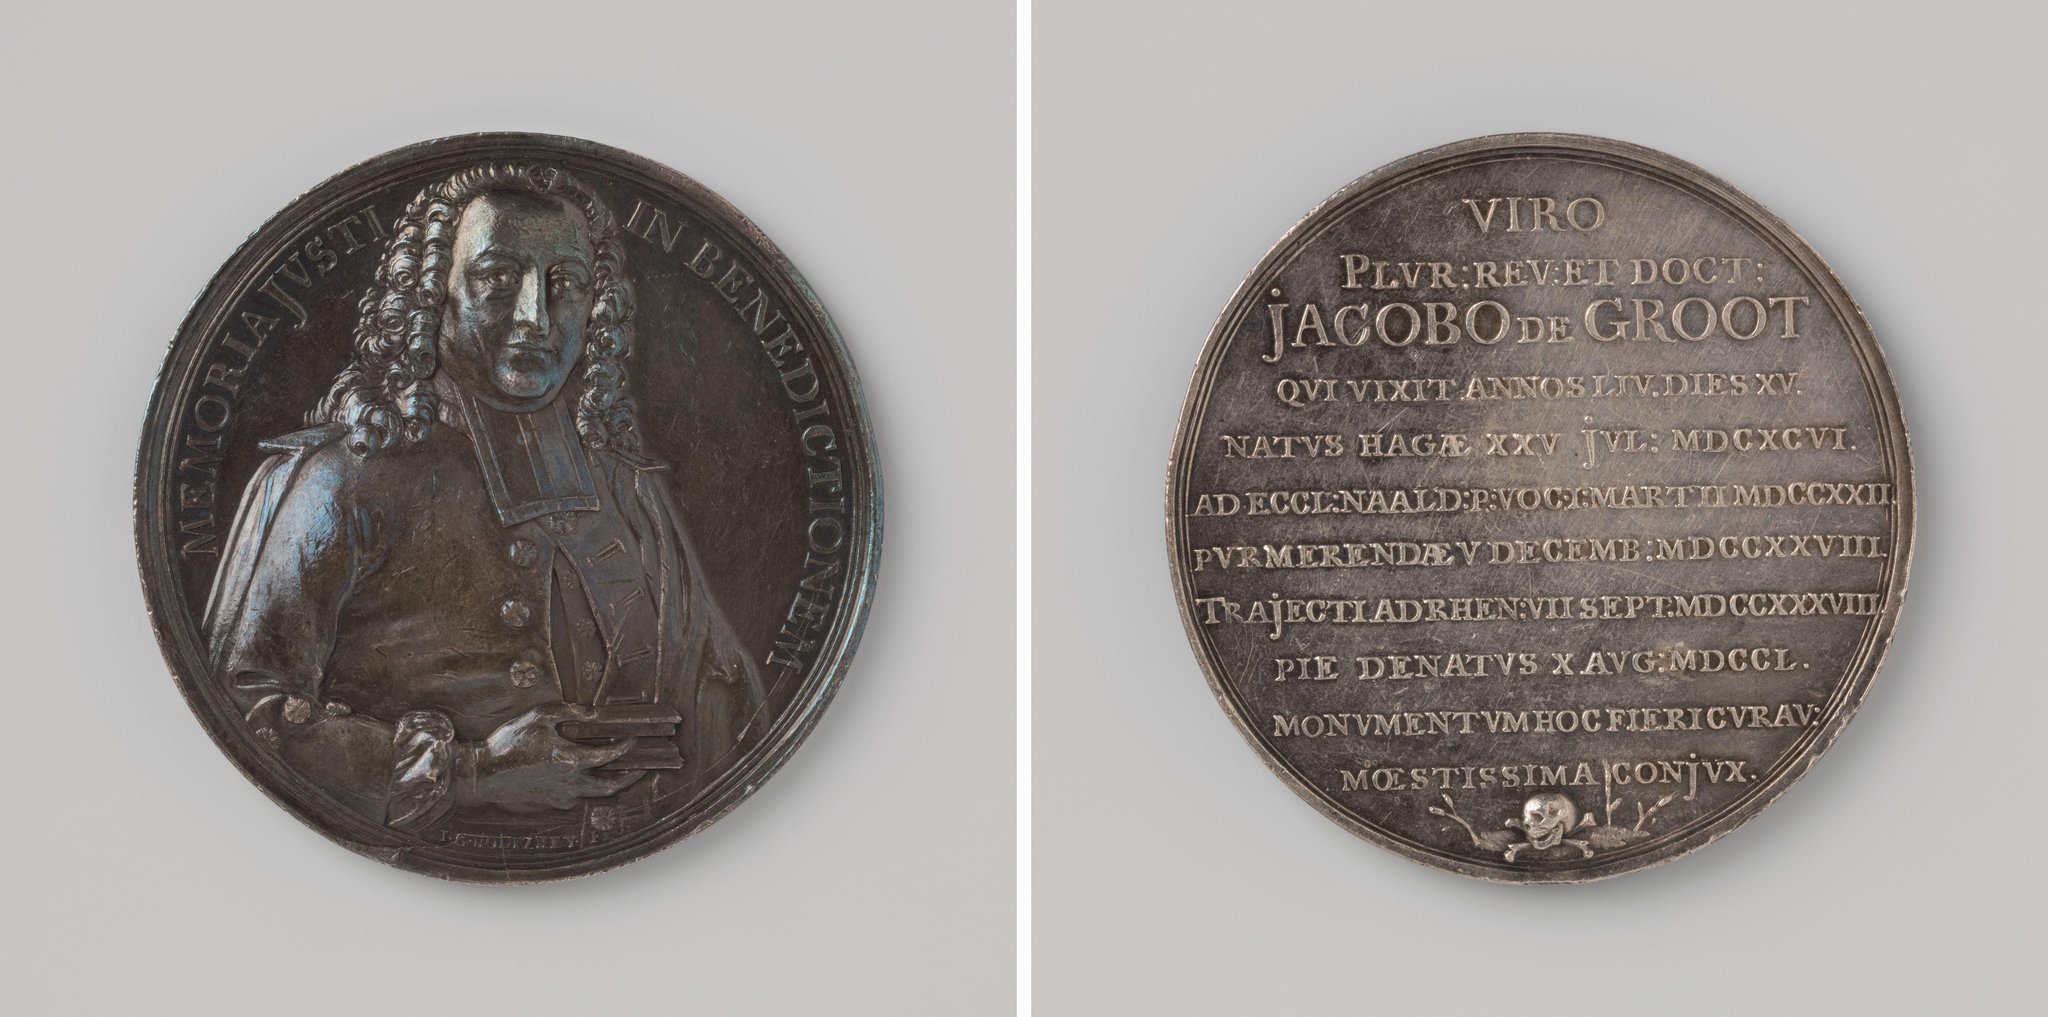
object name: history medal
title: Overlijden van Jacob de Groot 1750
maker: johan george holtzhey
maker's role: mintmaster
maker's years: 1726-1808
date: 1750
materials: silver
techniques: striking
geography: amsterdam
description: Zilveren penning, op de voorzijde het portret ten halven lijve van De Groot met gebedenboek, met omschrift, op de keerzijde elf regels tekst boven een doodshoofd en opkomend graan.